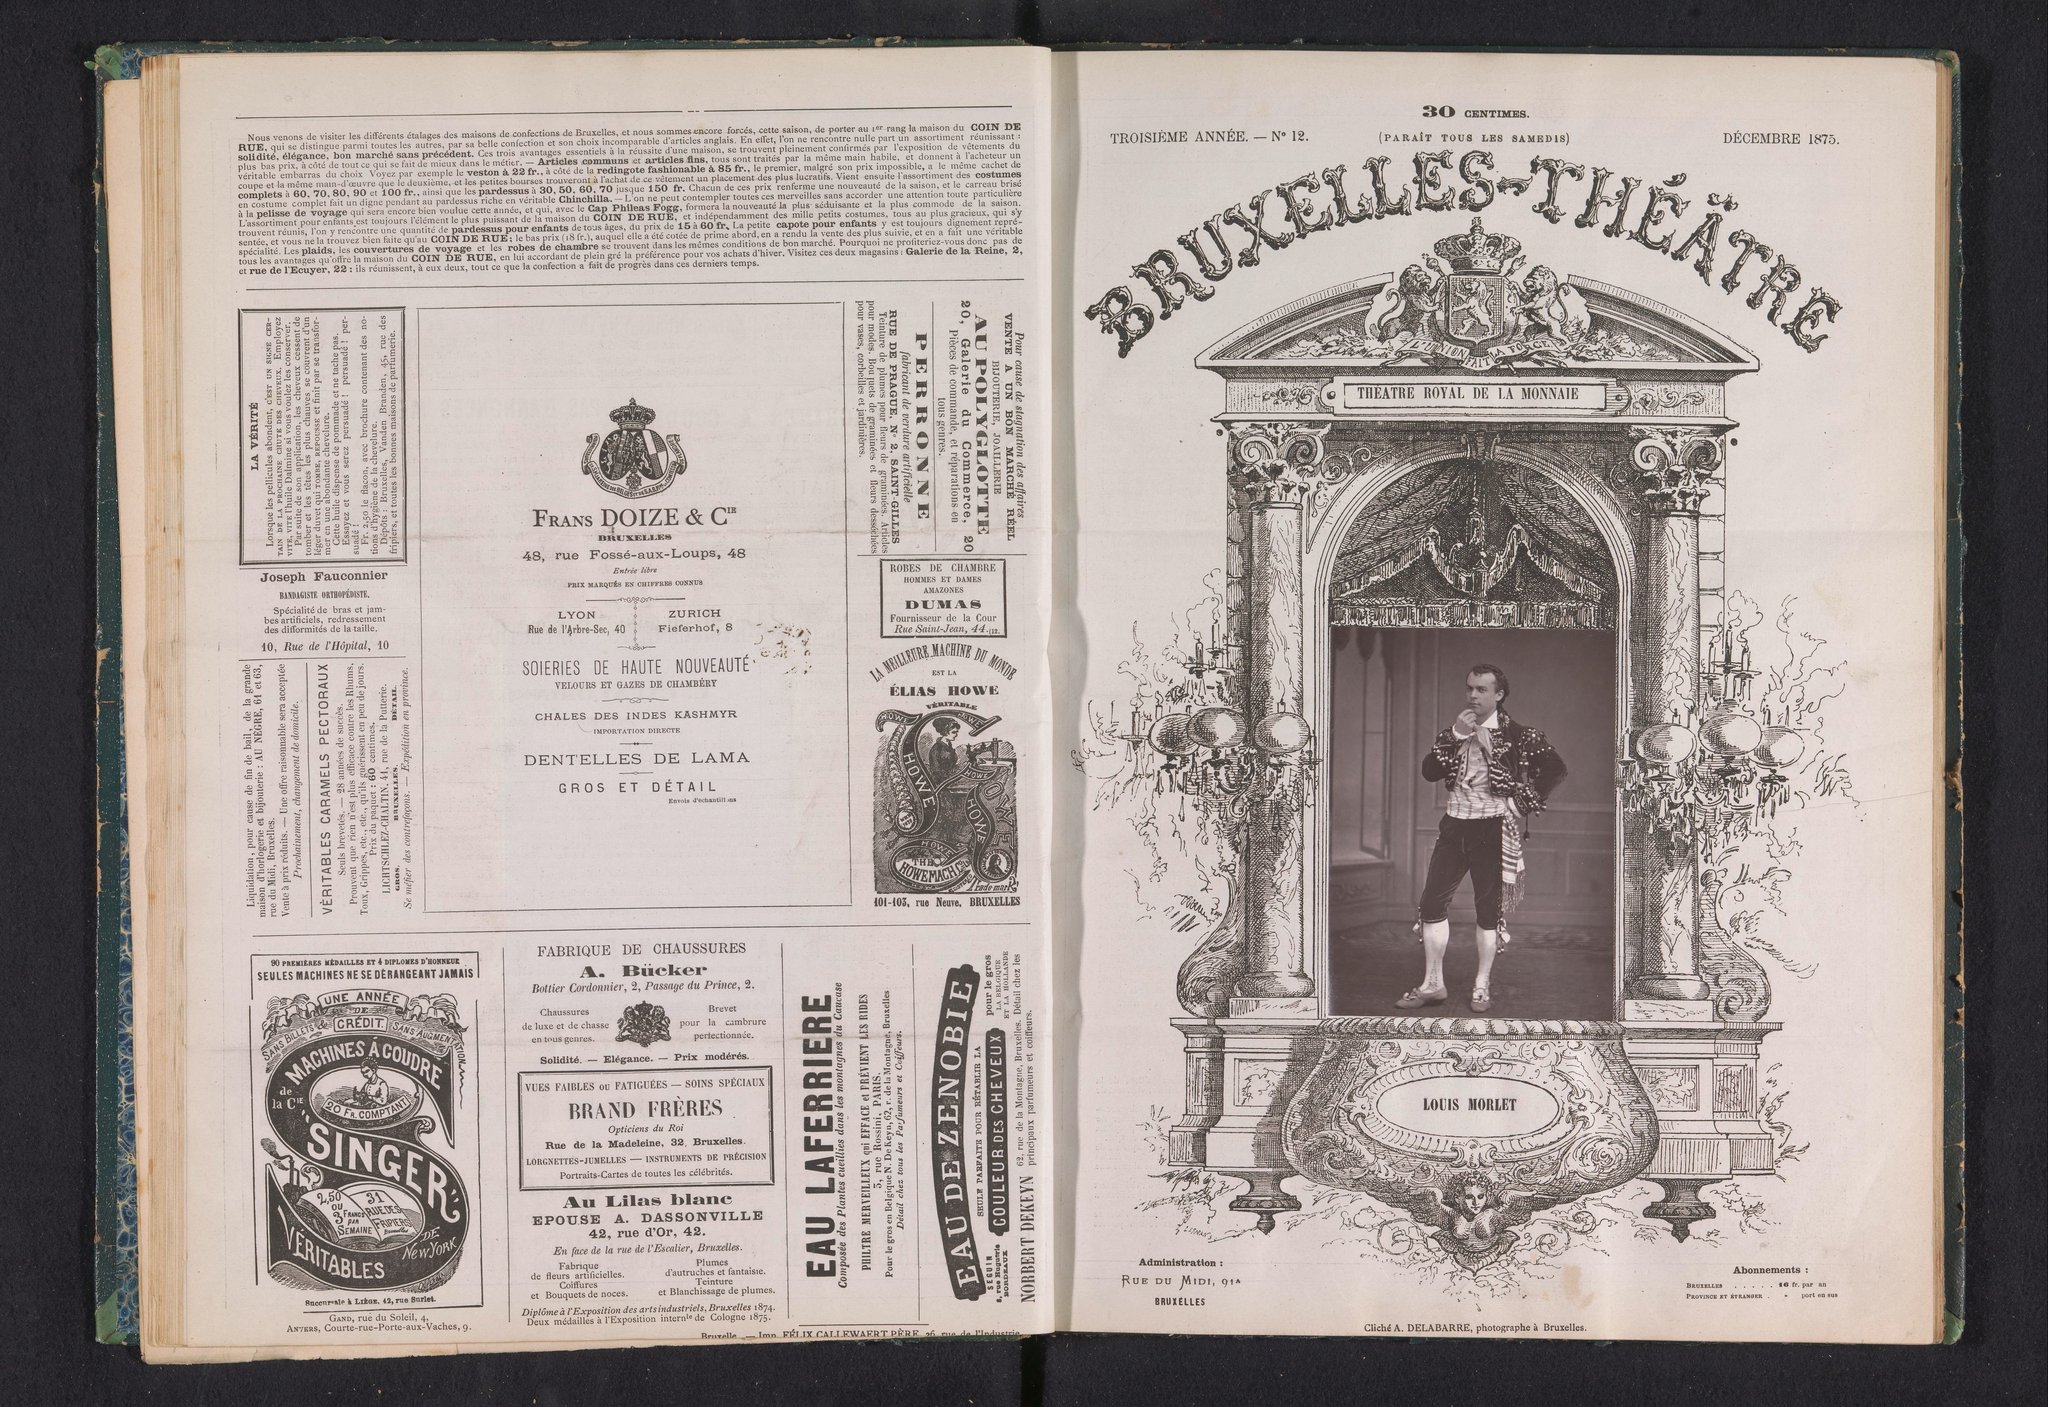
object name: page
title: Portret van Louis Morlet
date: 1870-1875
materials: paper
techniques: woodburytype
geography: brussels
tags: portrait of actor, actress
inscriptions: number: ‘No 12.’